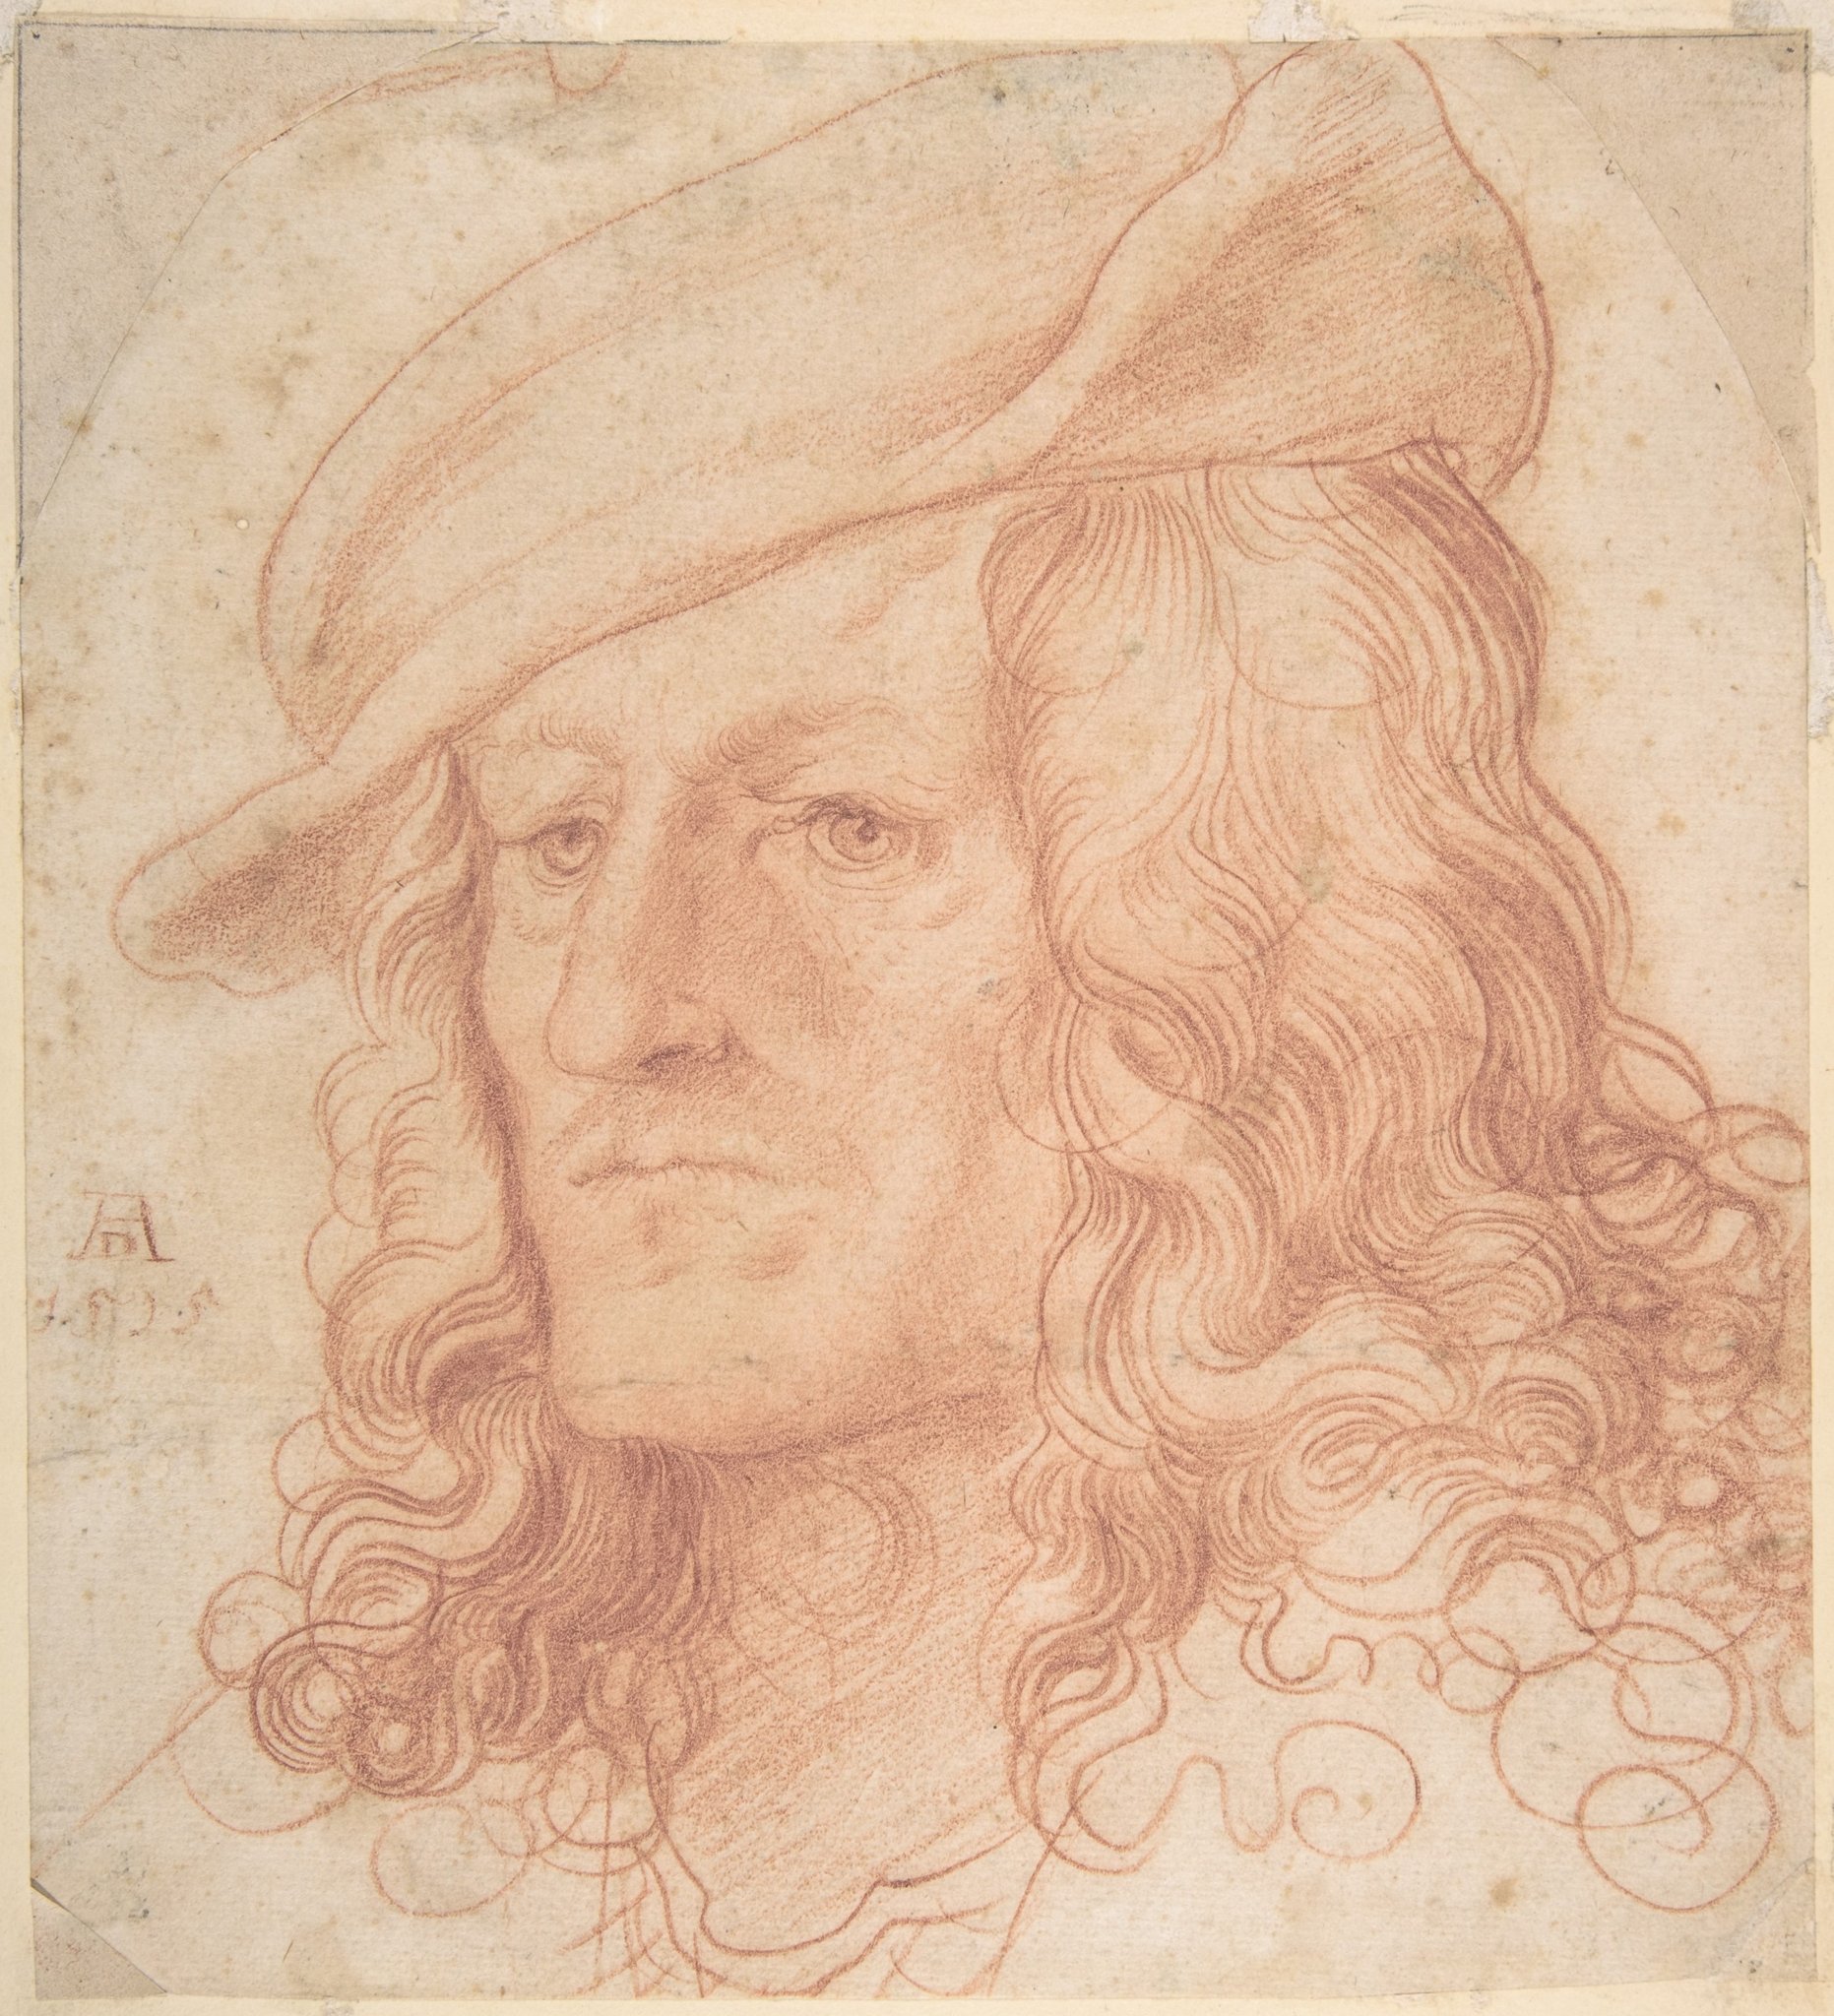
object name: drawing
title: Portrait of a man, bust-length, wearing a hat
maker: hans schäufelein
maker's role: artist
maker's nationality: german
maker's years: 1480-1540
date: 1510-1515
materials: chalk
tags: hats,men,portraits